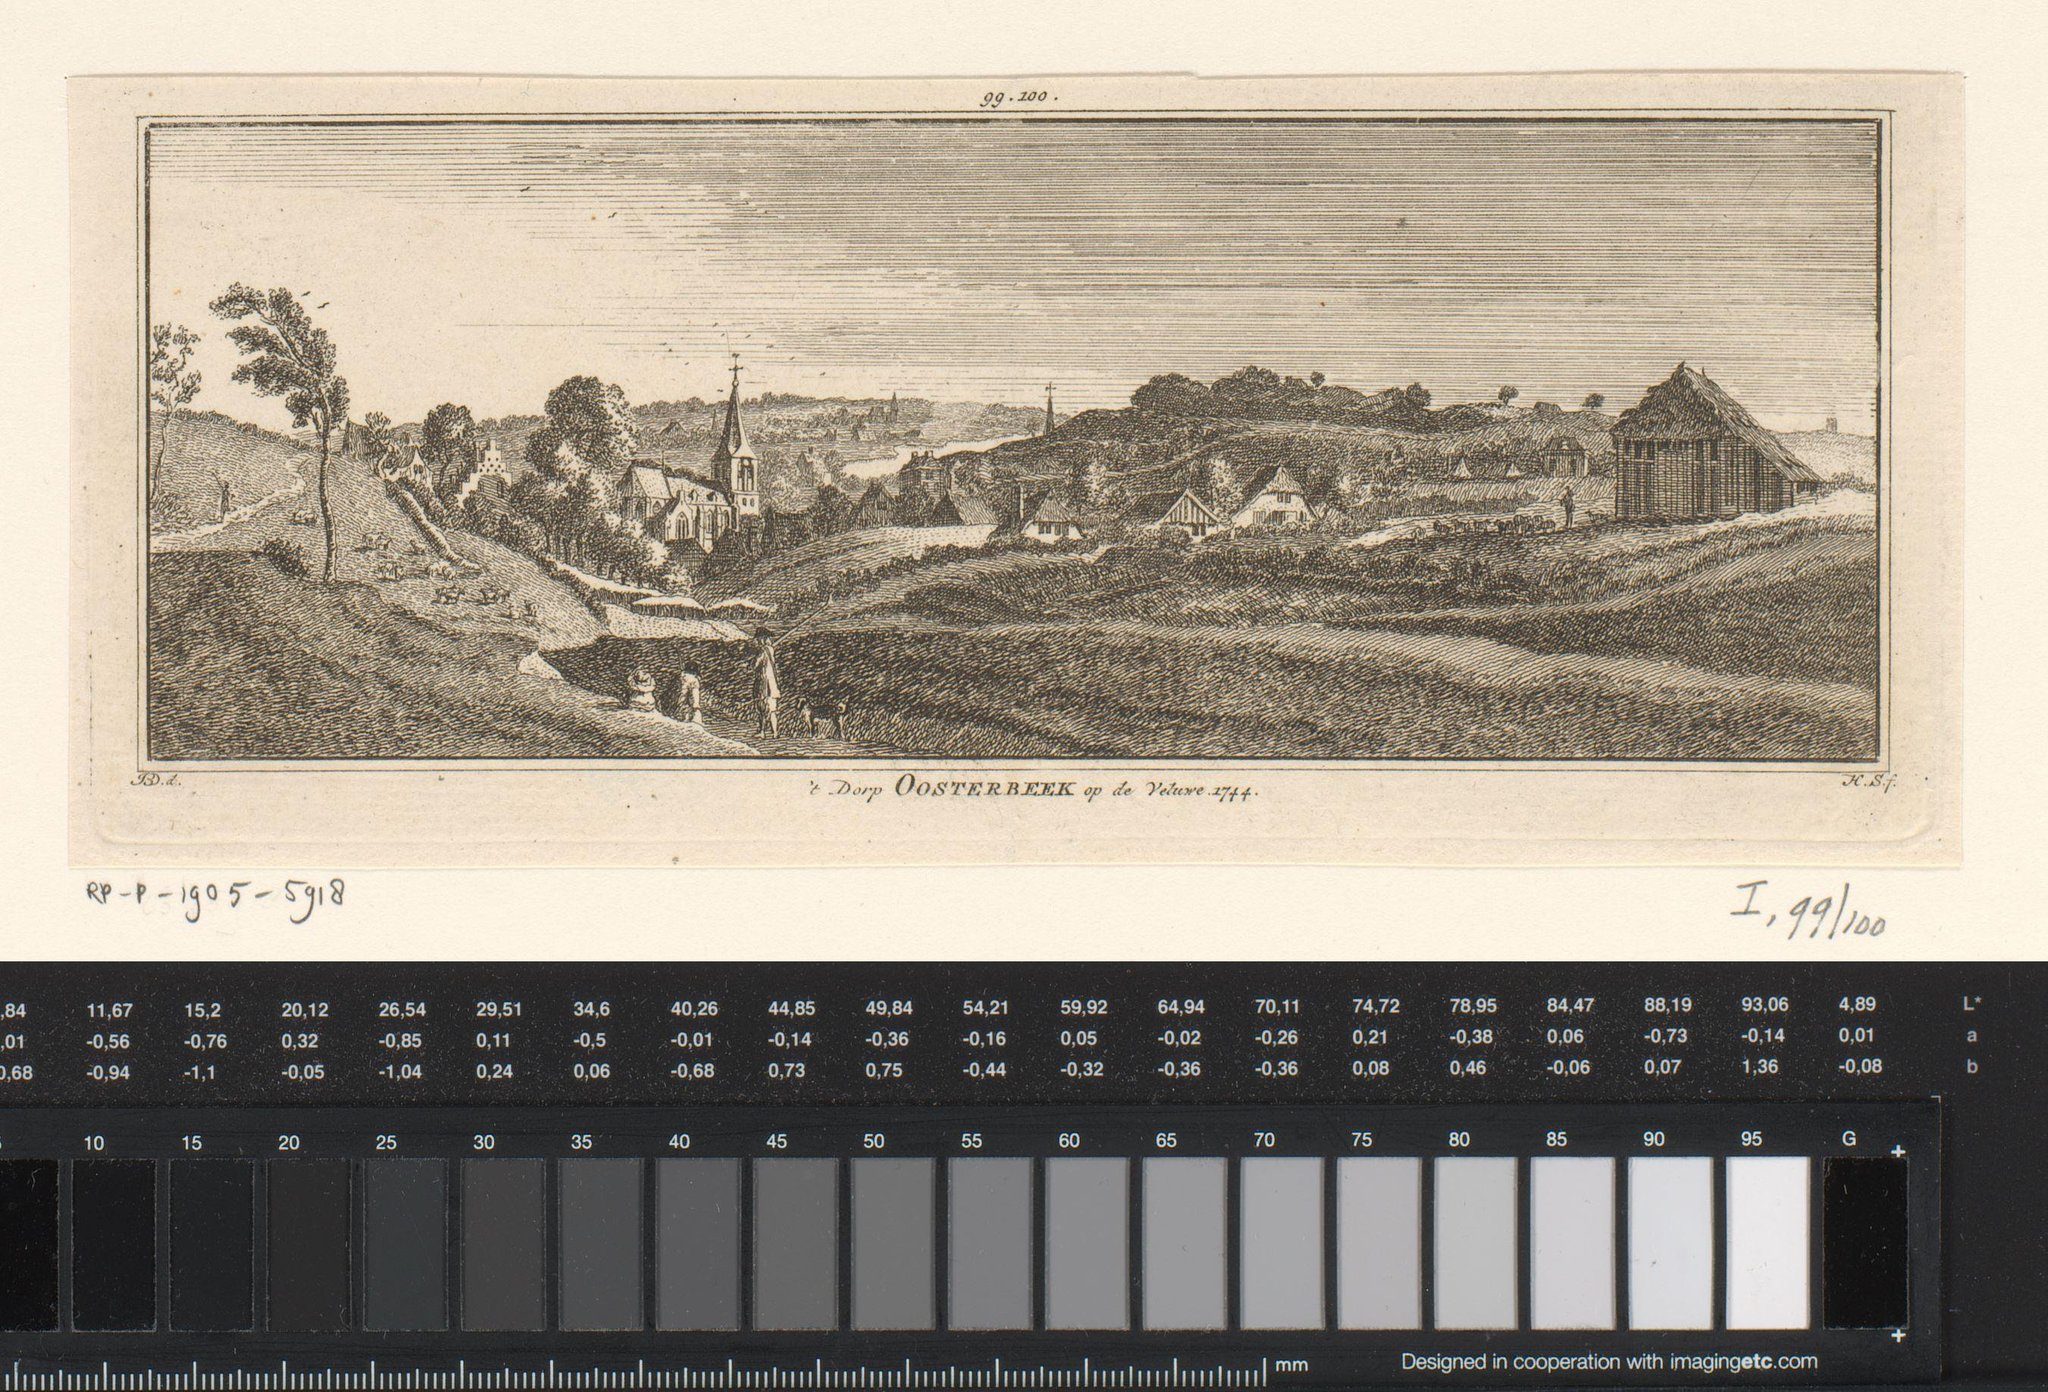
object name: print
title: 't Dorp Oosterbeek op de Veluwe 1744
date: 1745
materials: paper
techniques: etching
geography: haarlem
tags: outskirts of village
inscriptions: collector's mark: Lugt 2228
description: Prent gebruikt in: Het verheerlykt Nederland of kabinet van hedendaagsche gezigten van steden, dorpen, sloten ... en andere voornaame stad- en landgebouwen, in en omtrent alle de byzondere Vereenigde Nederlandsche Provinciën : gedurende de laatste jaaren door vermaarden kunsttekenaren na het leven getekent en ... in 't koper gebragt ... dienende tot opheldering der beschryvinge van den Tegenwoordigen Staat der Vereenigde Nederlanden. Deel I, 1745. Amsterdam: Isaac Tirion, 1745-1774.